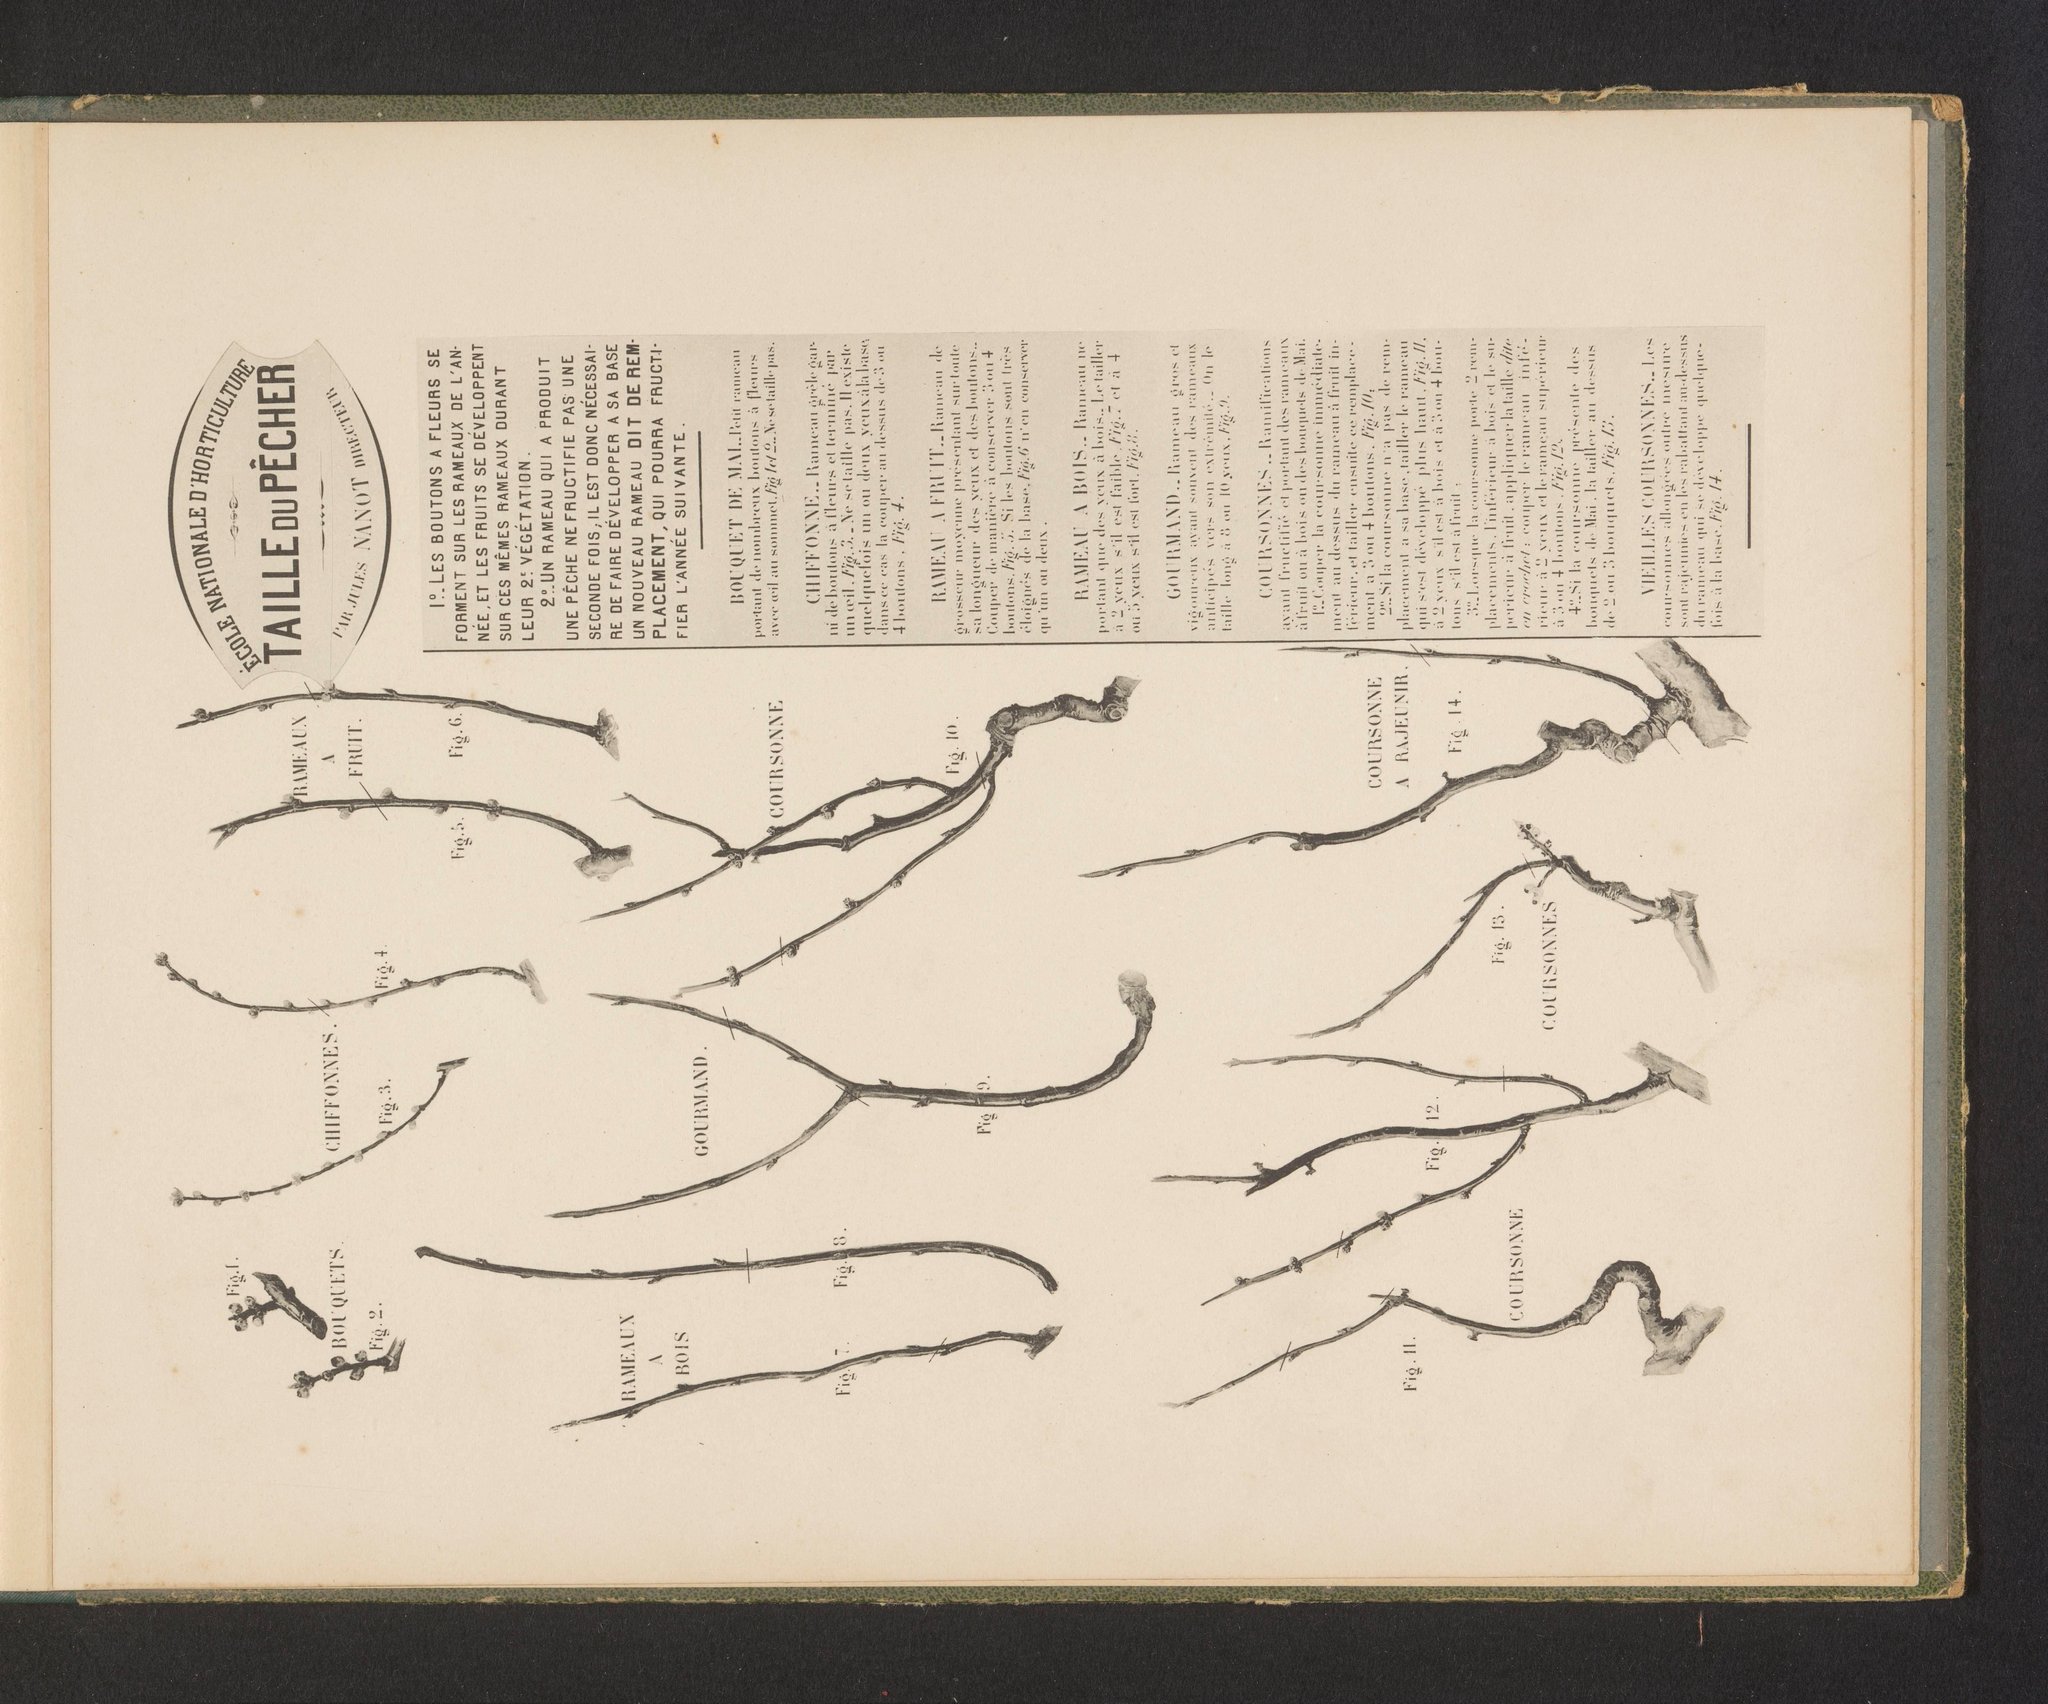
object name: page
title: Veertien reproducties van ontwerpen van fragmenten van takken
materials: paper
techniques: photograph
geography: versailles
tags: horticulture, vegetable culture, market gardening, trees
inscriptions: inscription: ‘(...)’